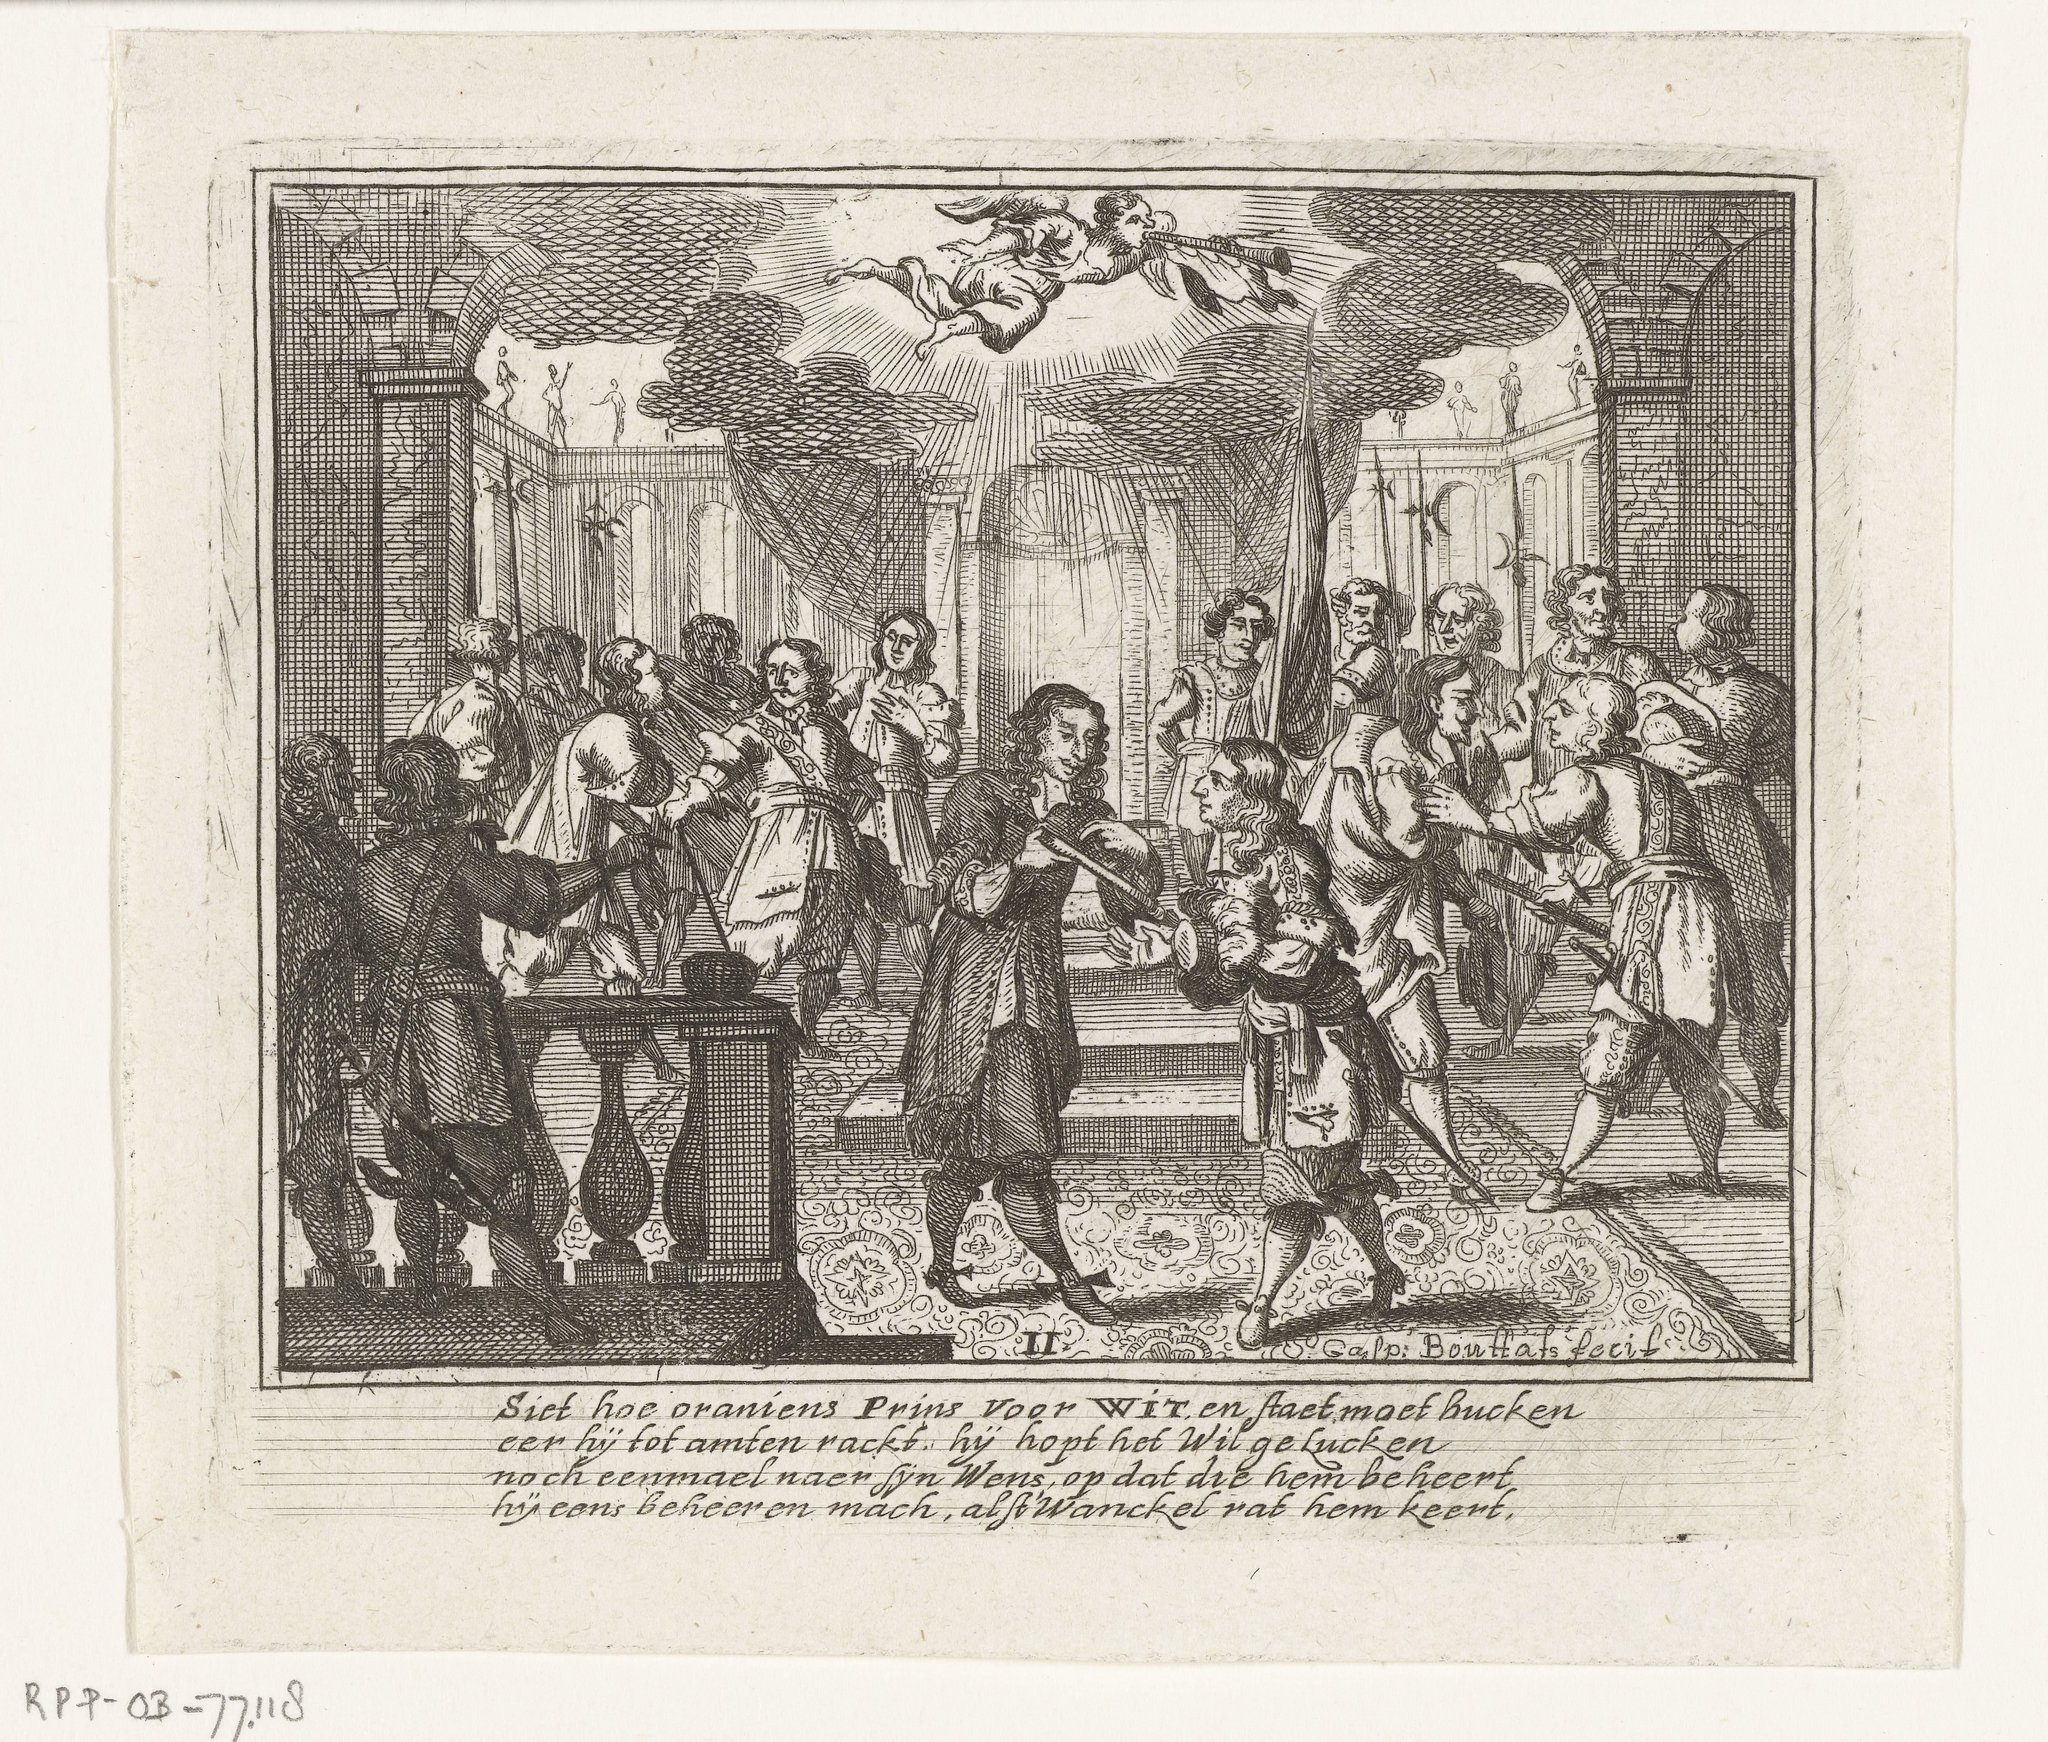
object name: print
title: De prins van Oranje moet buigen voor Johan de Witt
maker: gaspar bouttats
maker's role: print maker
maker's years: 1640-1695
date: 1672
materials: paper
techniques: etching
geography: antwerp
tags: dordrecht, cornelis de witt, the hague, politician, johan de witt, william iii (prince of orange and king of england, scotland, and ireland)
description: Tweede prent in een reeks van acht voorstellingen over het leven van Johan en Cornelis de Witt. Alle prenten zijn van de hand van Gaspar Bouttats en hebben een vers van vier of twee regels. In de voorstelling is te zien hoe prins Willem III aan Johan de Witt en de Staten toestemming moet vragen voor zijn benoeming.